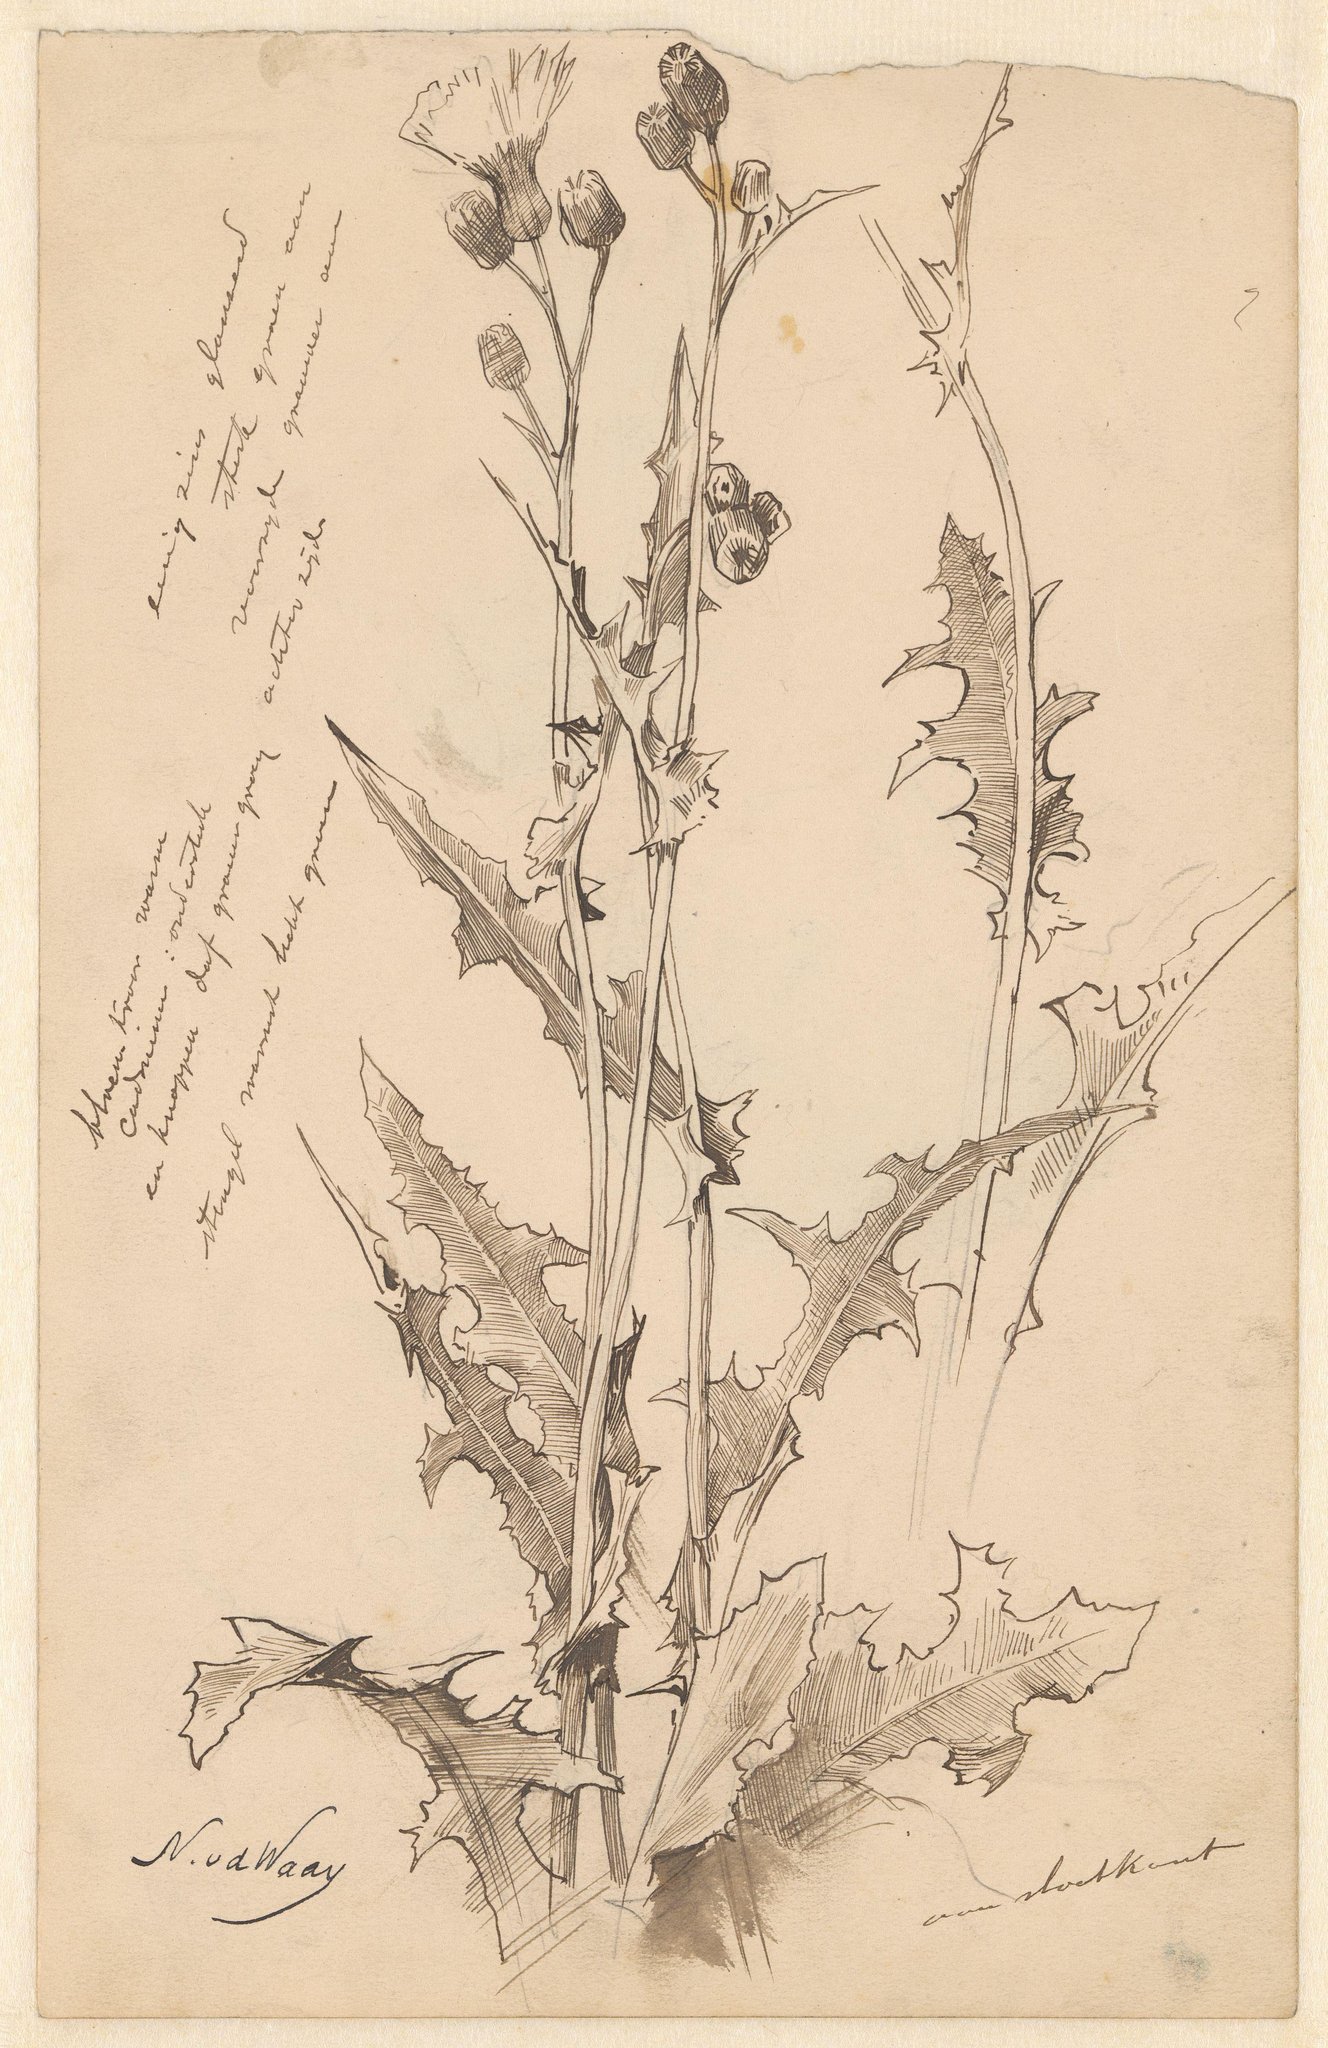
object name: drawing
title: Distel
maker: nicolaas van der waay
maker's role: draughtsman, painter, print maker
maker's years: 1855-1936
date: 1865-1936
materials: ink, paper, pencil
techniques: pen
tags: plants and herbs: thistle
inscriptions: annotation: ‘aan slootkant’